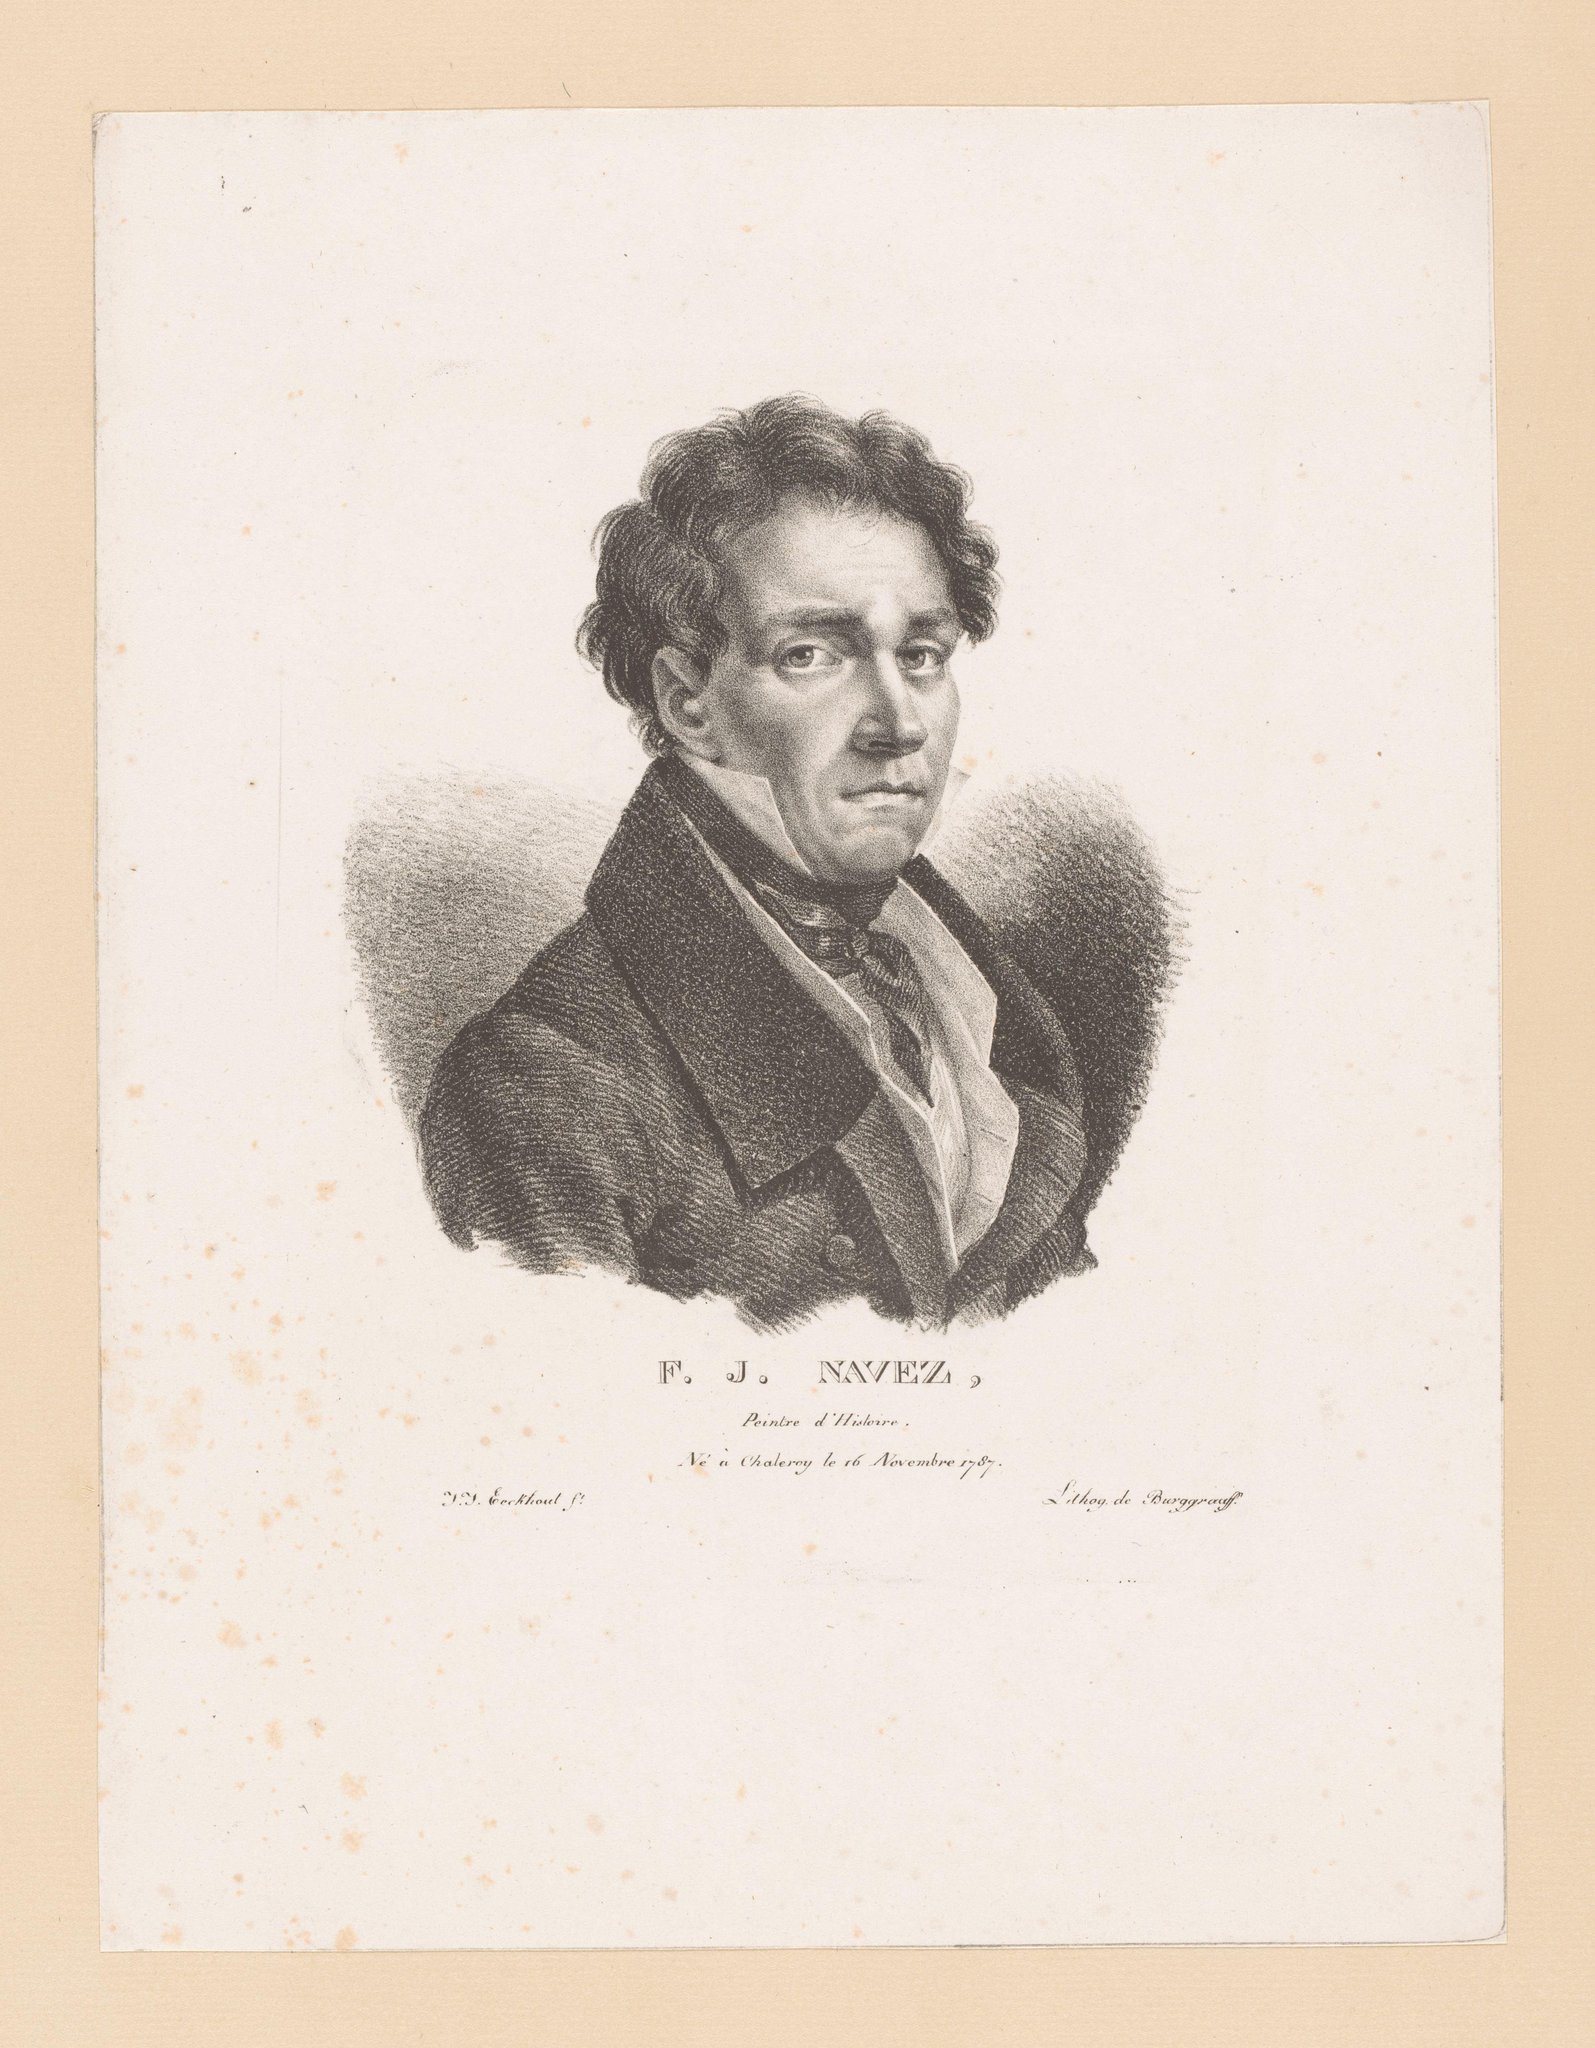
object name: print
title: Portret van François Joseph Navez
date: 1822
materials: paper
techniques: lithograph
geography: brussels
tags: painter, print maker, draughtsman, françois joseph navez, historical persons, portrait, self-portrait of painter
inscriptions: collector's mark: Lugt 2228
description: Prent maakt deel uit van een serie van zestig prenten.